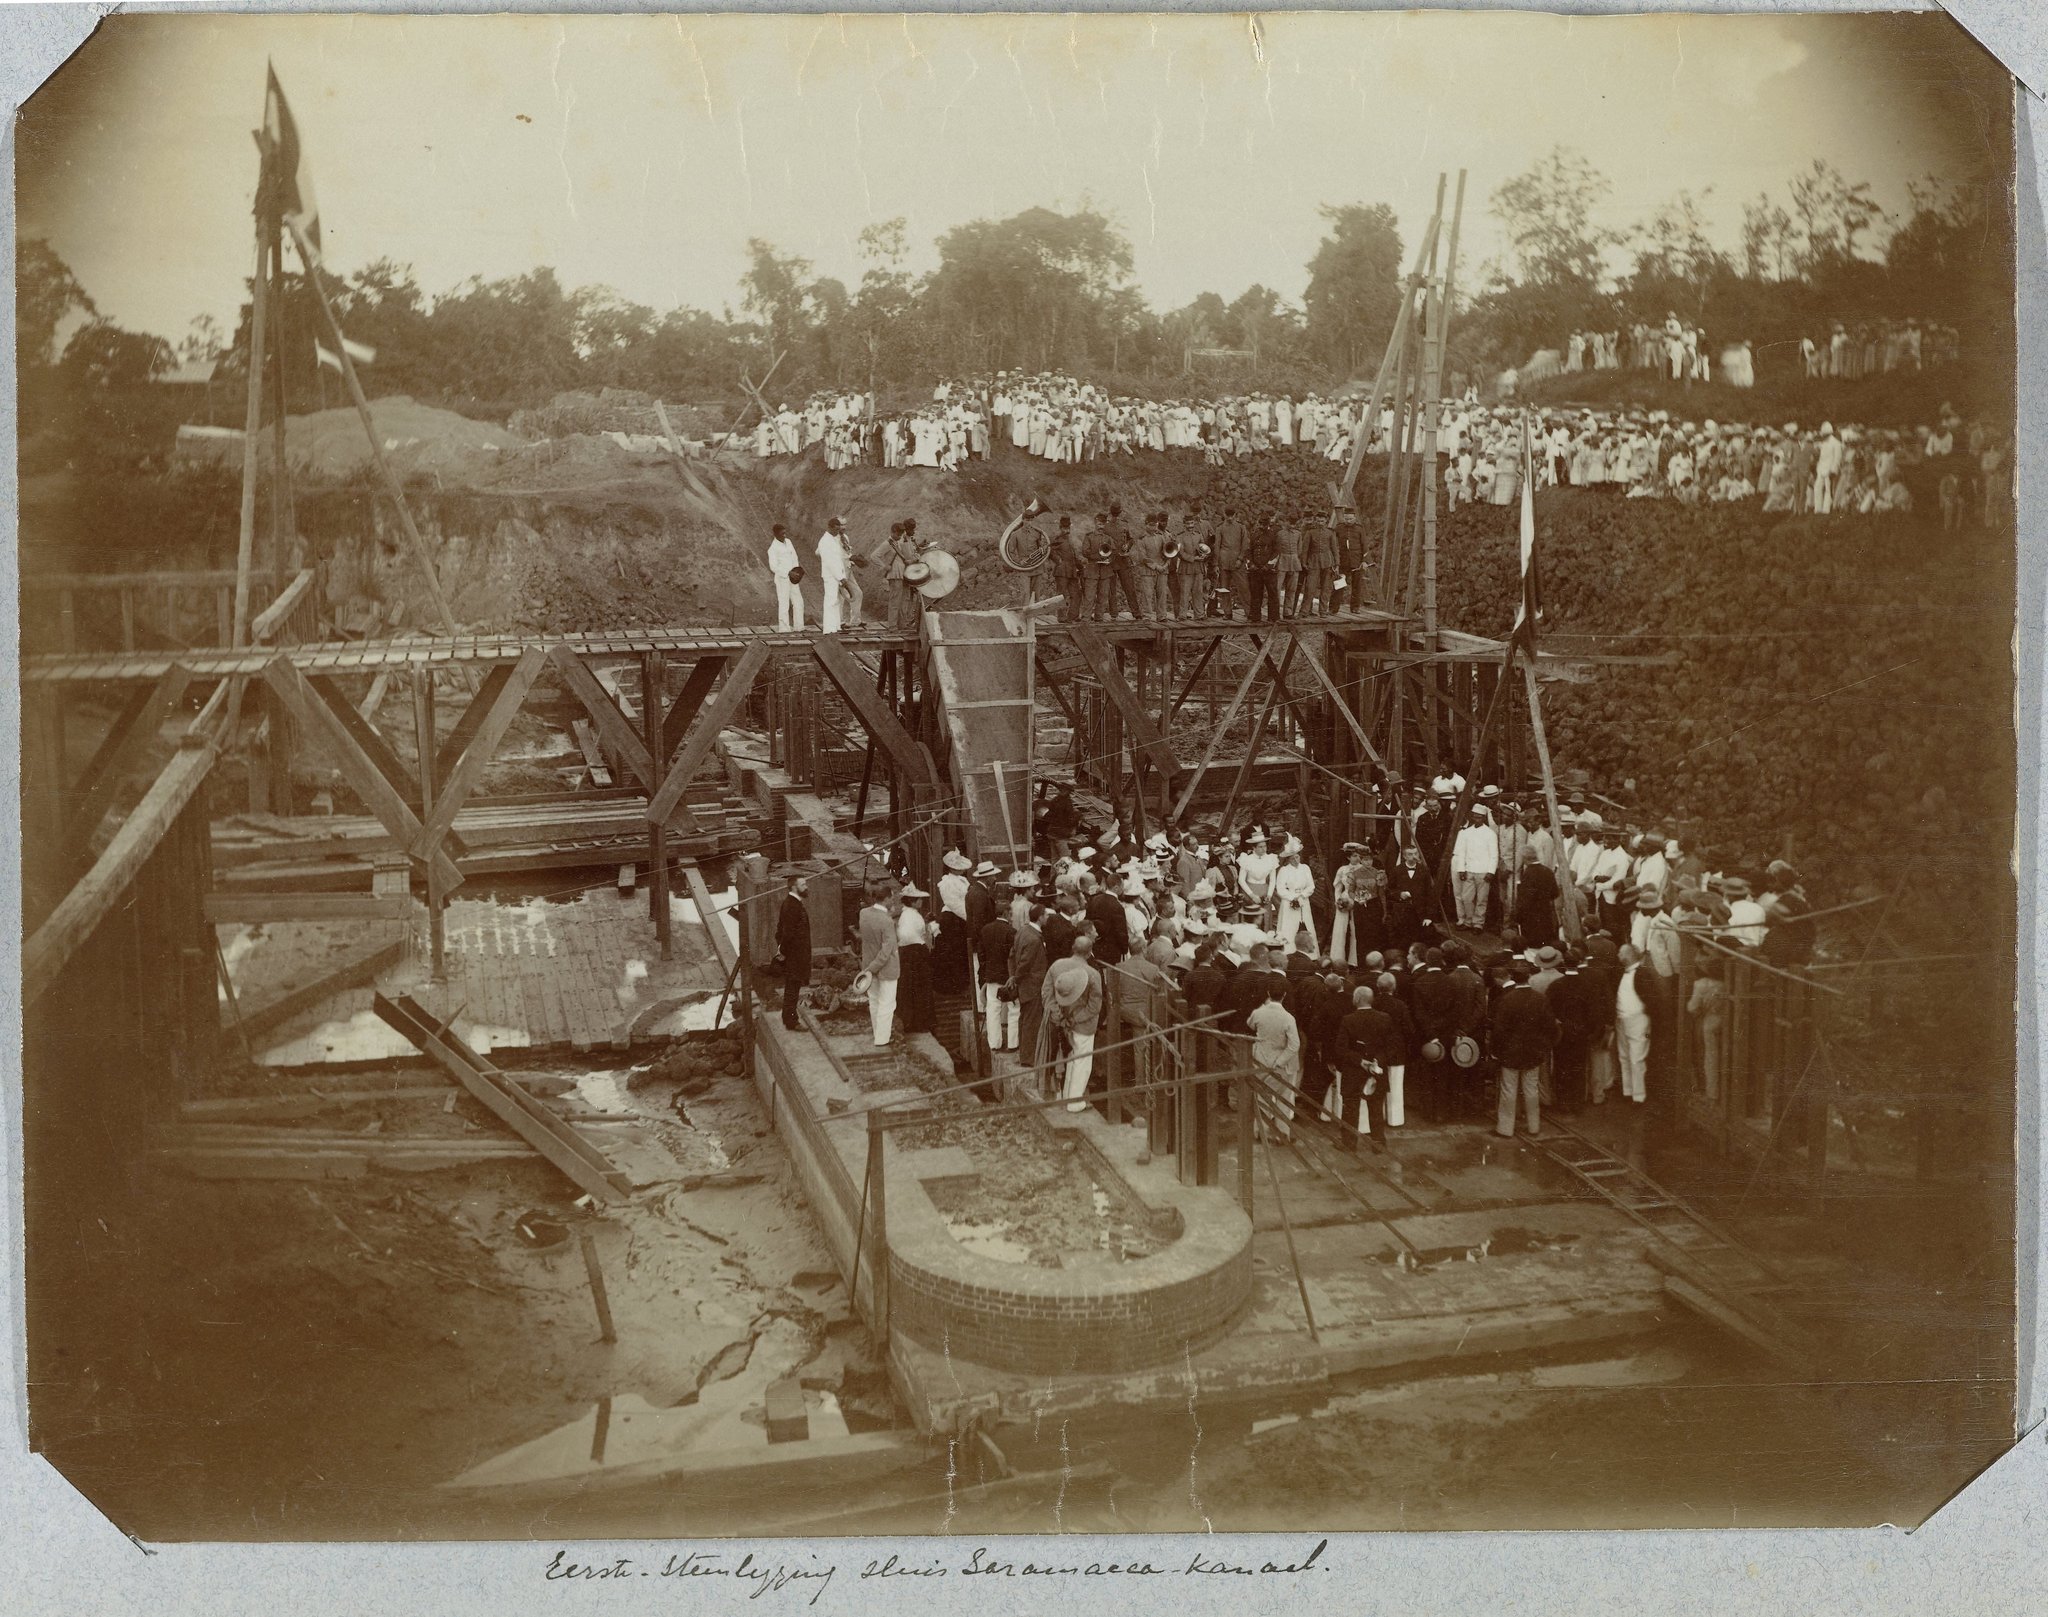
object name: photograph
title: Eerste steenlegging sluis Saramacca-kanaal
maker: théodore van lelyveld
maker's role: painter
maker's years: 1867-1954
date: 1895-1898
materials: photographic support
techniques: collodion silver print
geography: suriname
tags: the hague, théodore van lelyveld, ceremonial laying of the foundations, laying the first stone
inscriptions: inscription: ‘Eerste steenlegging sluis Saramacca-kanaal.’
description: De ceremoniële eerstesteenlegging voor de sluis in de Saramacca Kanaal te Paramaribo. In de bouwput de gouverneur Titus van Asch van Wijck omringd door een grote groep toeschouwers, op de bouwstelling een muziekkorps. Op het hoger gelegen grond een grote groep Surinamers. Fotoafdruk in een fotoalbum van Théodore van Lelyveld over Suriname uit 1895-1898.